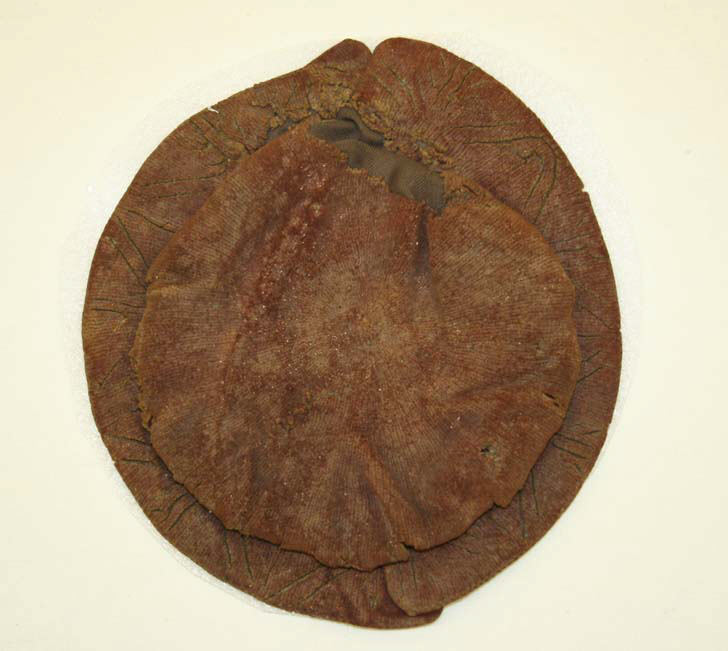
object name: cap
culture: british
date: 1501-1600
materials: wool